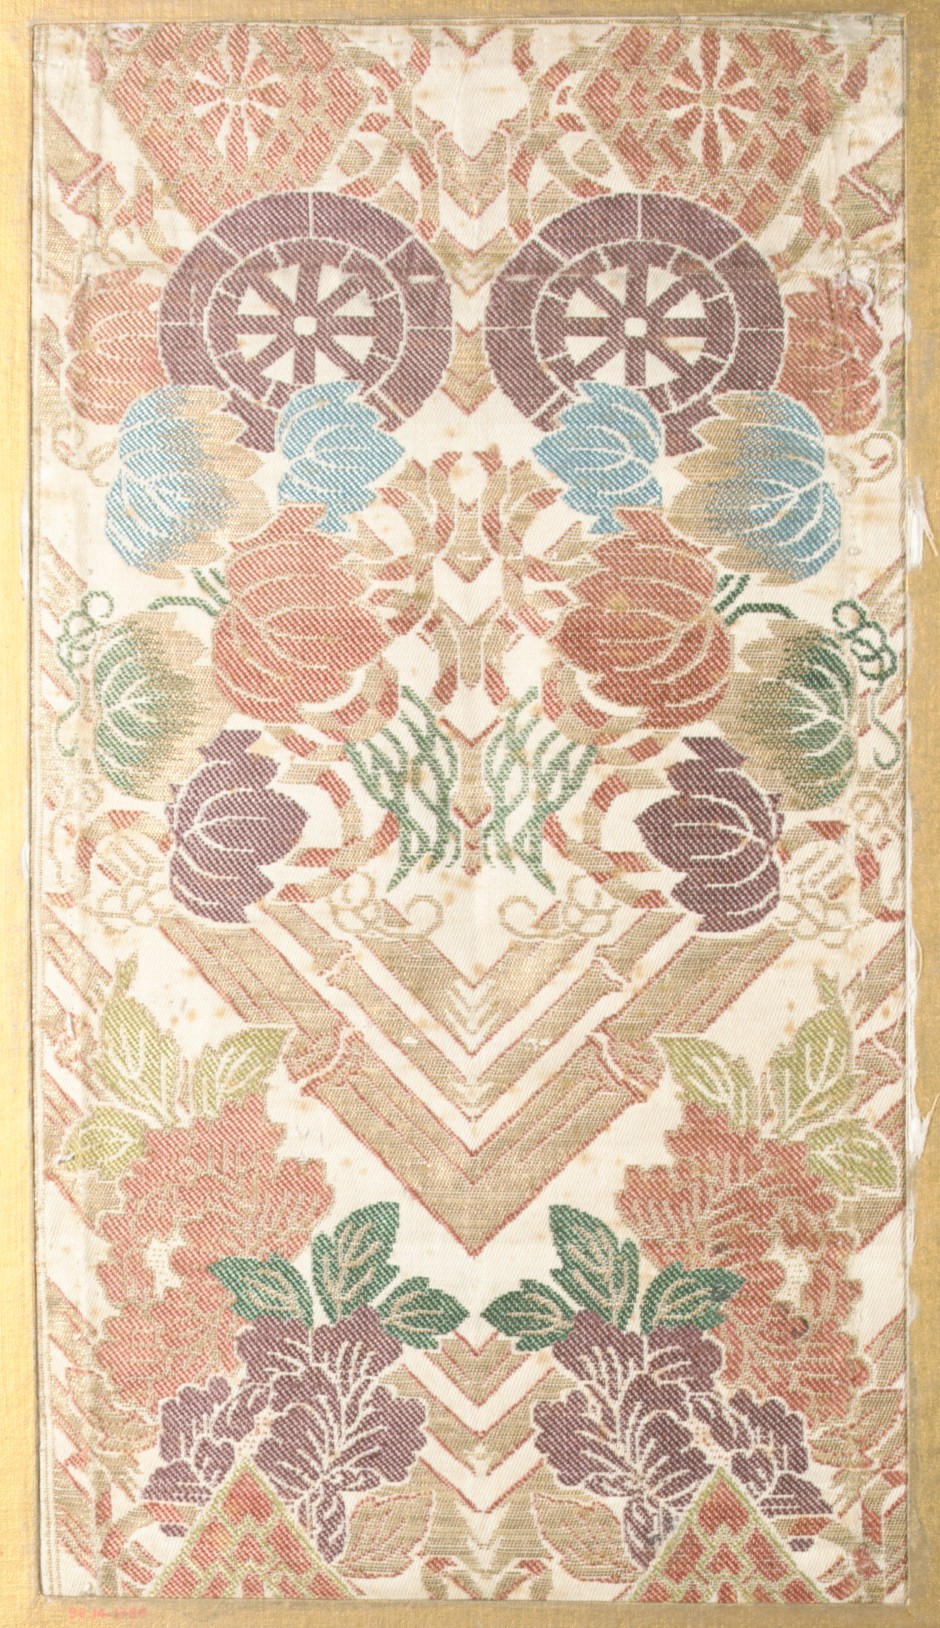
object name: piece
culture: japanese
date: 1701-1900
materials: silk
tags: flowers